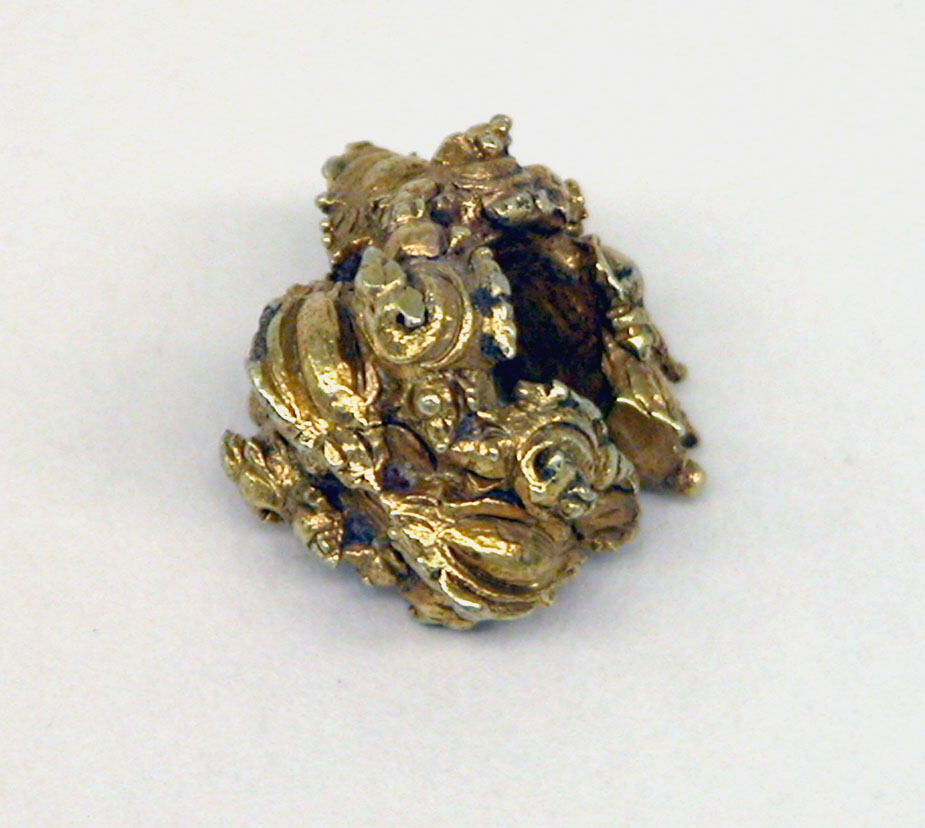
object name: ear ornament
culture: indonesian, javanese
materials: gold